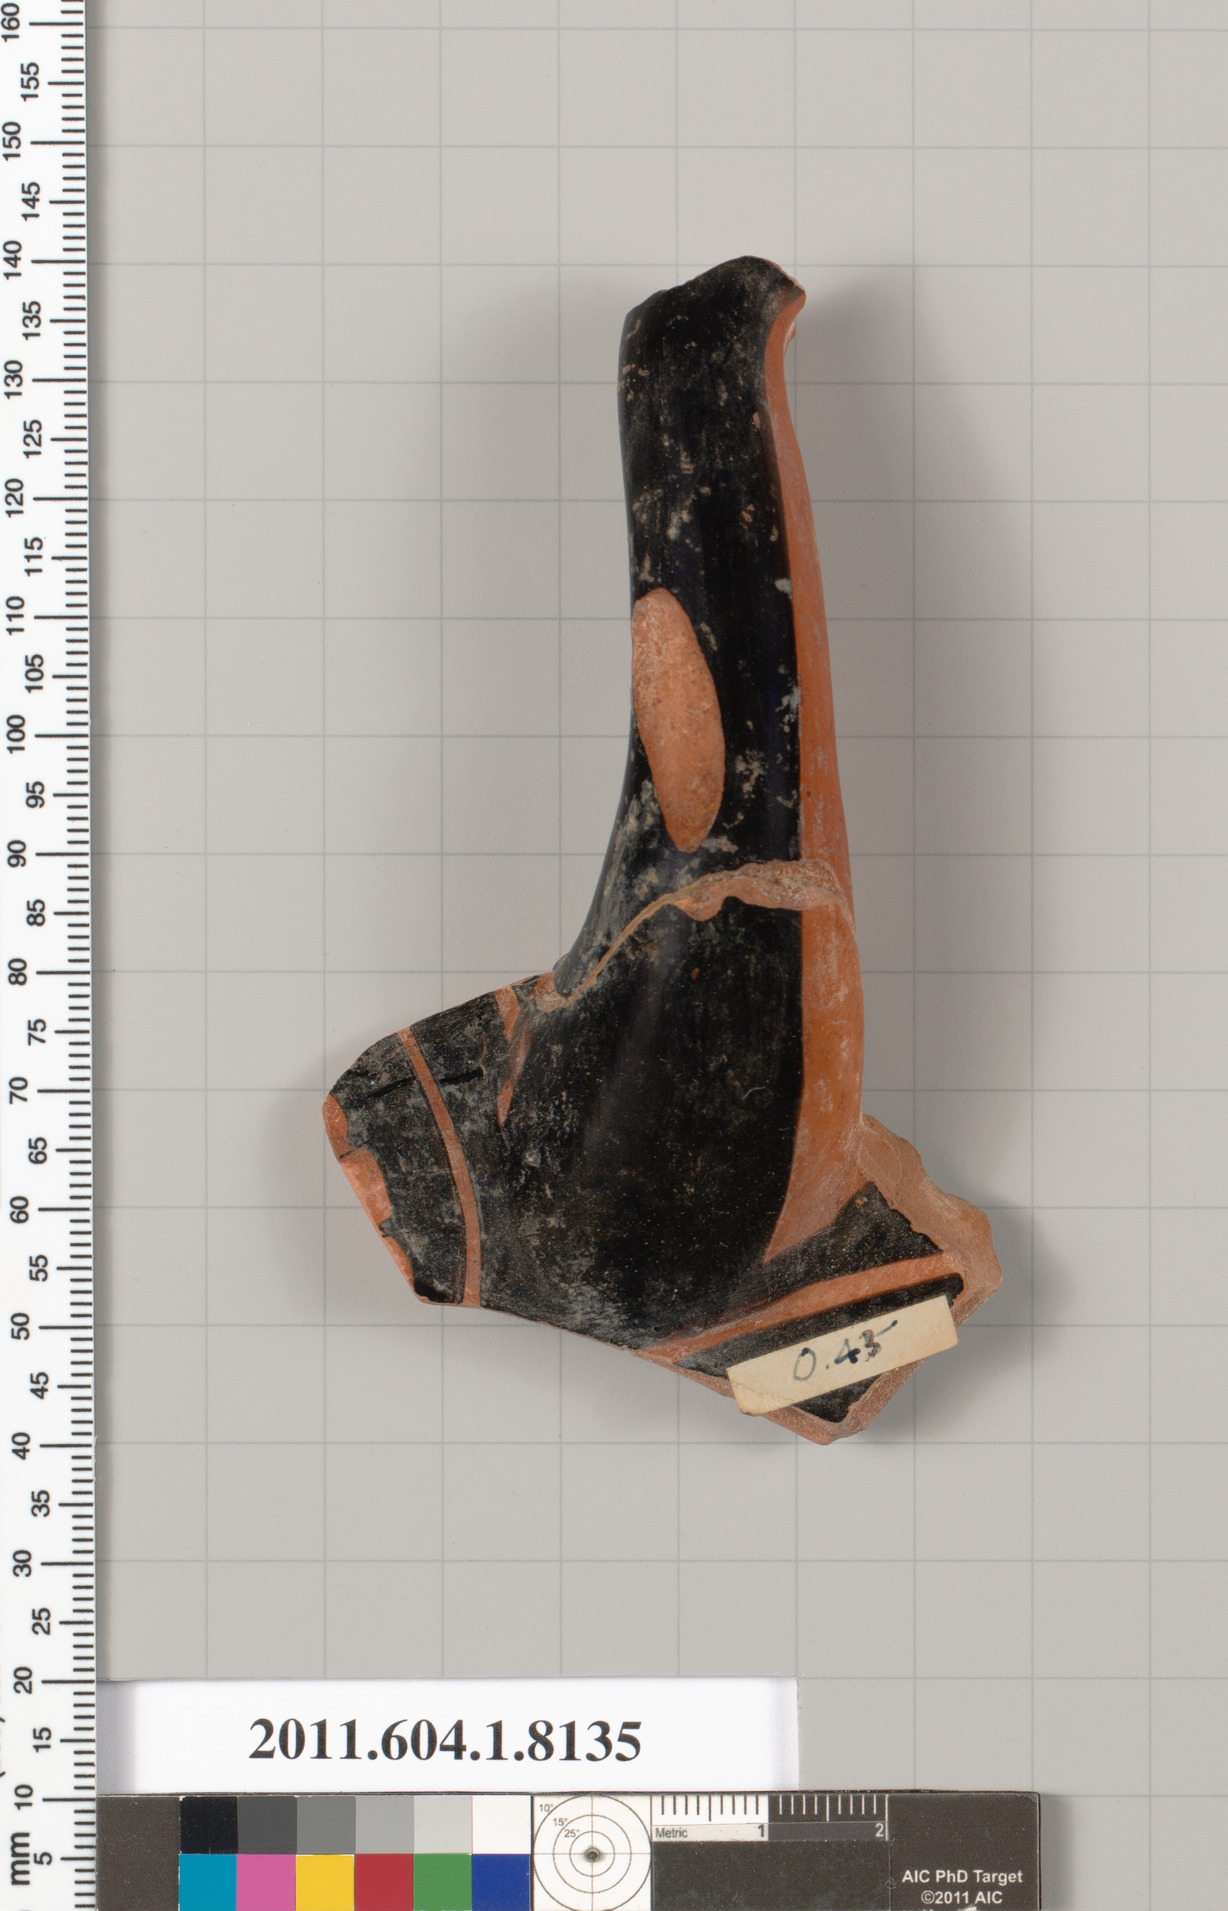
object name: kylix fragment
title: Terracotta fragment of a kylix (drinking cup)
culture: greek, attic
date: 534-468 BCE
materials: terracotta